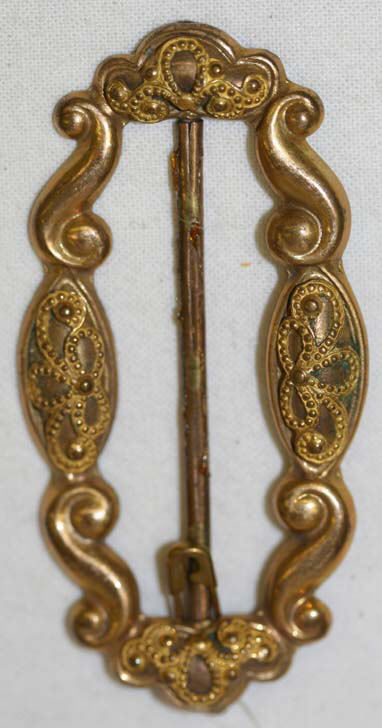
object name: belt buckle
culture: european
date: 1840-1849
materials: gold